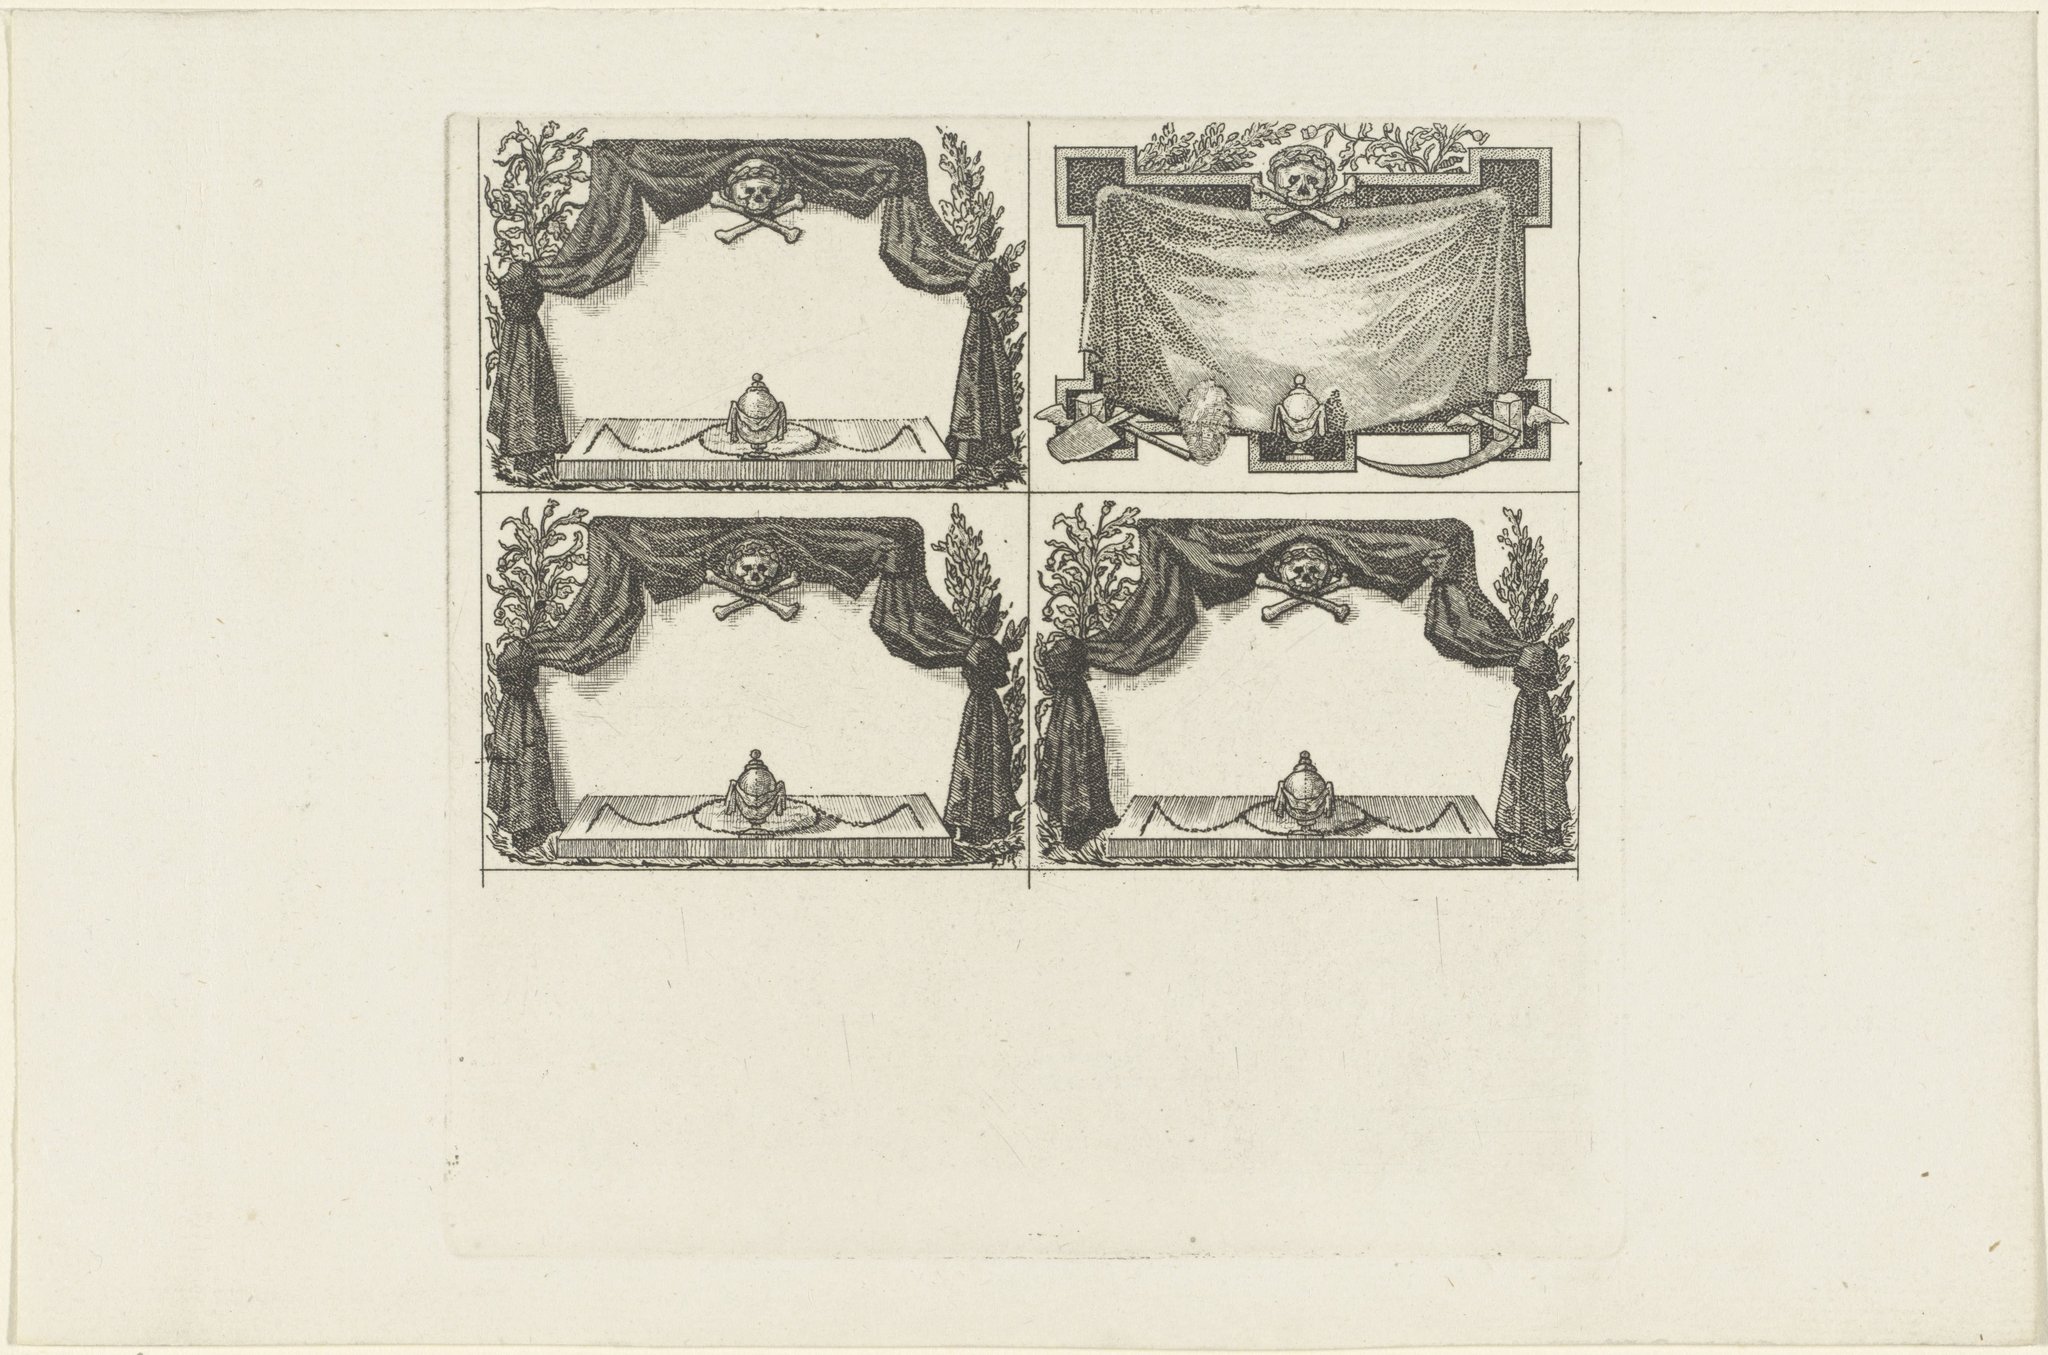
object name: print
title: Ontwerpen voor rouwaankondigingen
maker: jacob schwartzenbach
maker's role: draughtsman, painter, print maker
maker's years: 1763-1805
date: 1773-1805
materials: paper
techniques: etching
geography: veere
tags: urn, death's head, skull (symbol of death)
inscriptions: collector's mark: Lugt 2228